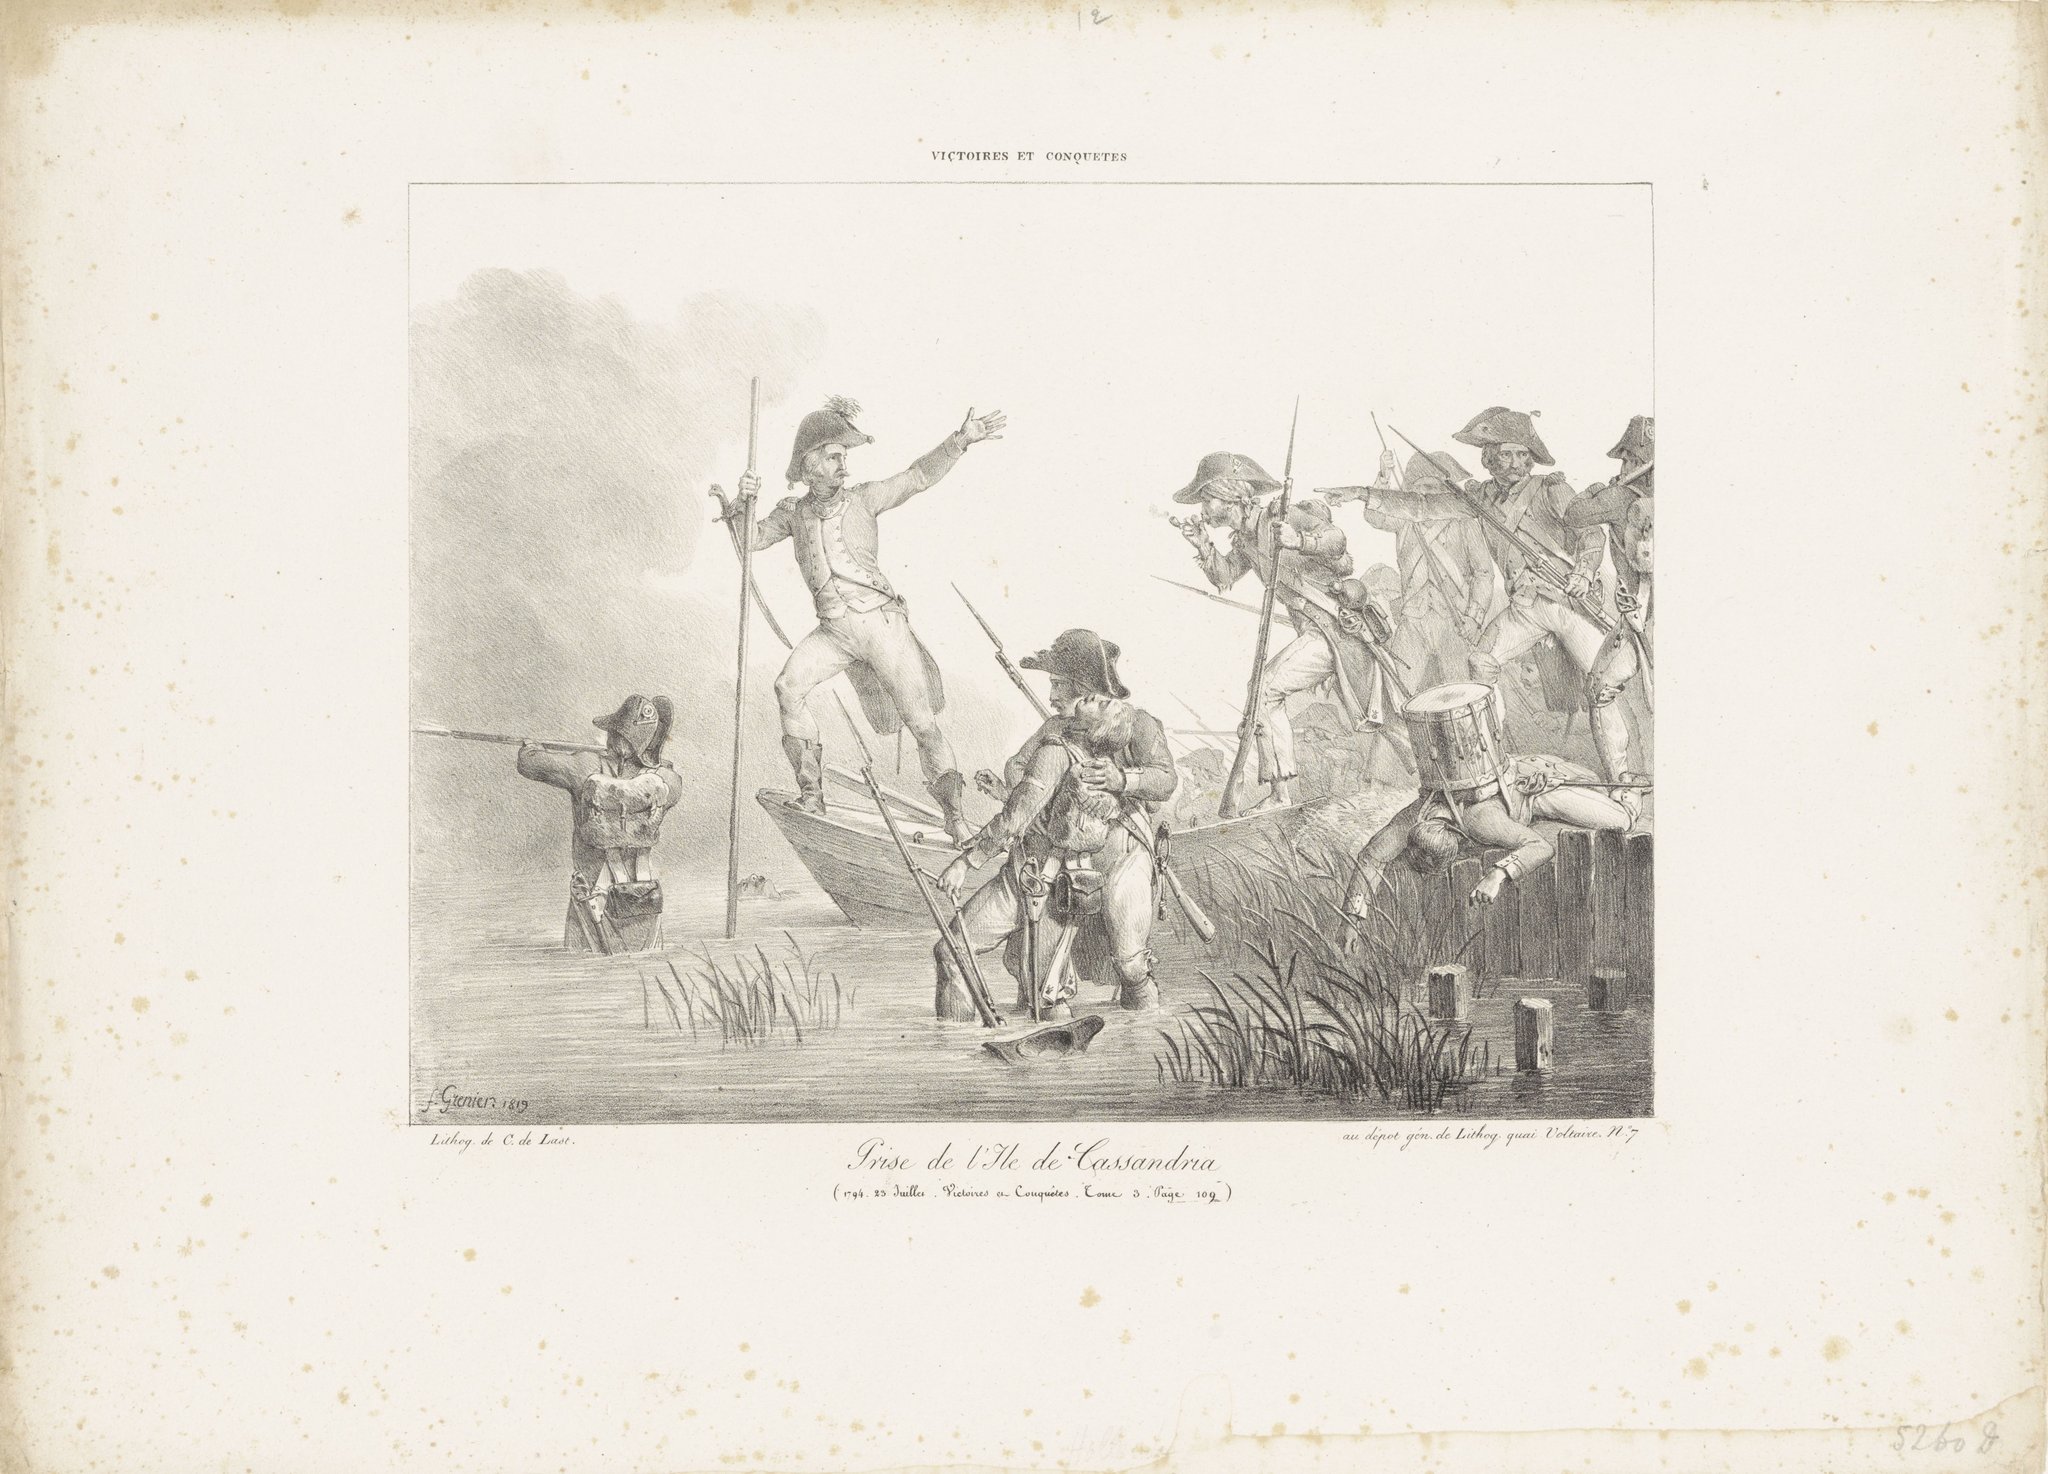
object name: history print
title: Inname van het land van Cadzand, 1794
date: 1819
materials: paper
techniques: lithograph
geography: france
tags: battle (+ land forces)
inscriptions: collector's mark: Lugt 2228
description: Franse heldenmoed tijdens de inname van het 'eiland Cassandria'. Dit is het zgn 'land van Cadzand' gelegen tegenover Sluis in Zeeuws-Vlaanderen, 23 juli 1794.